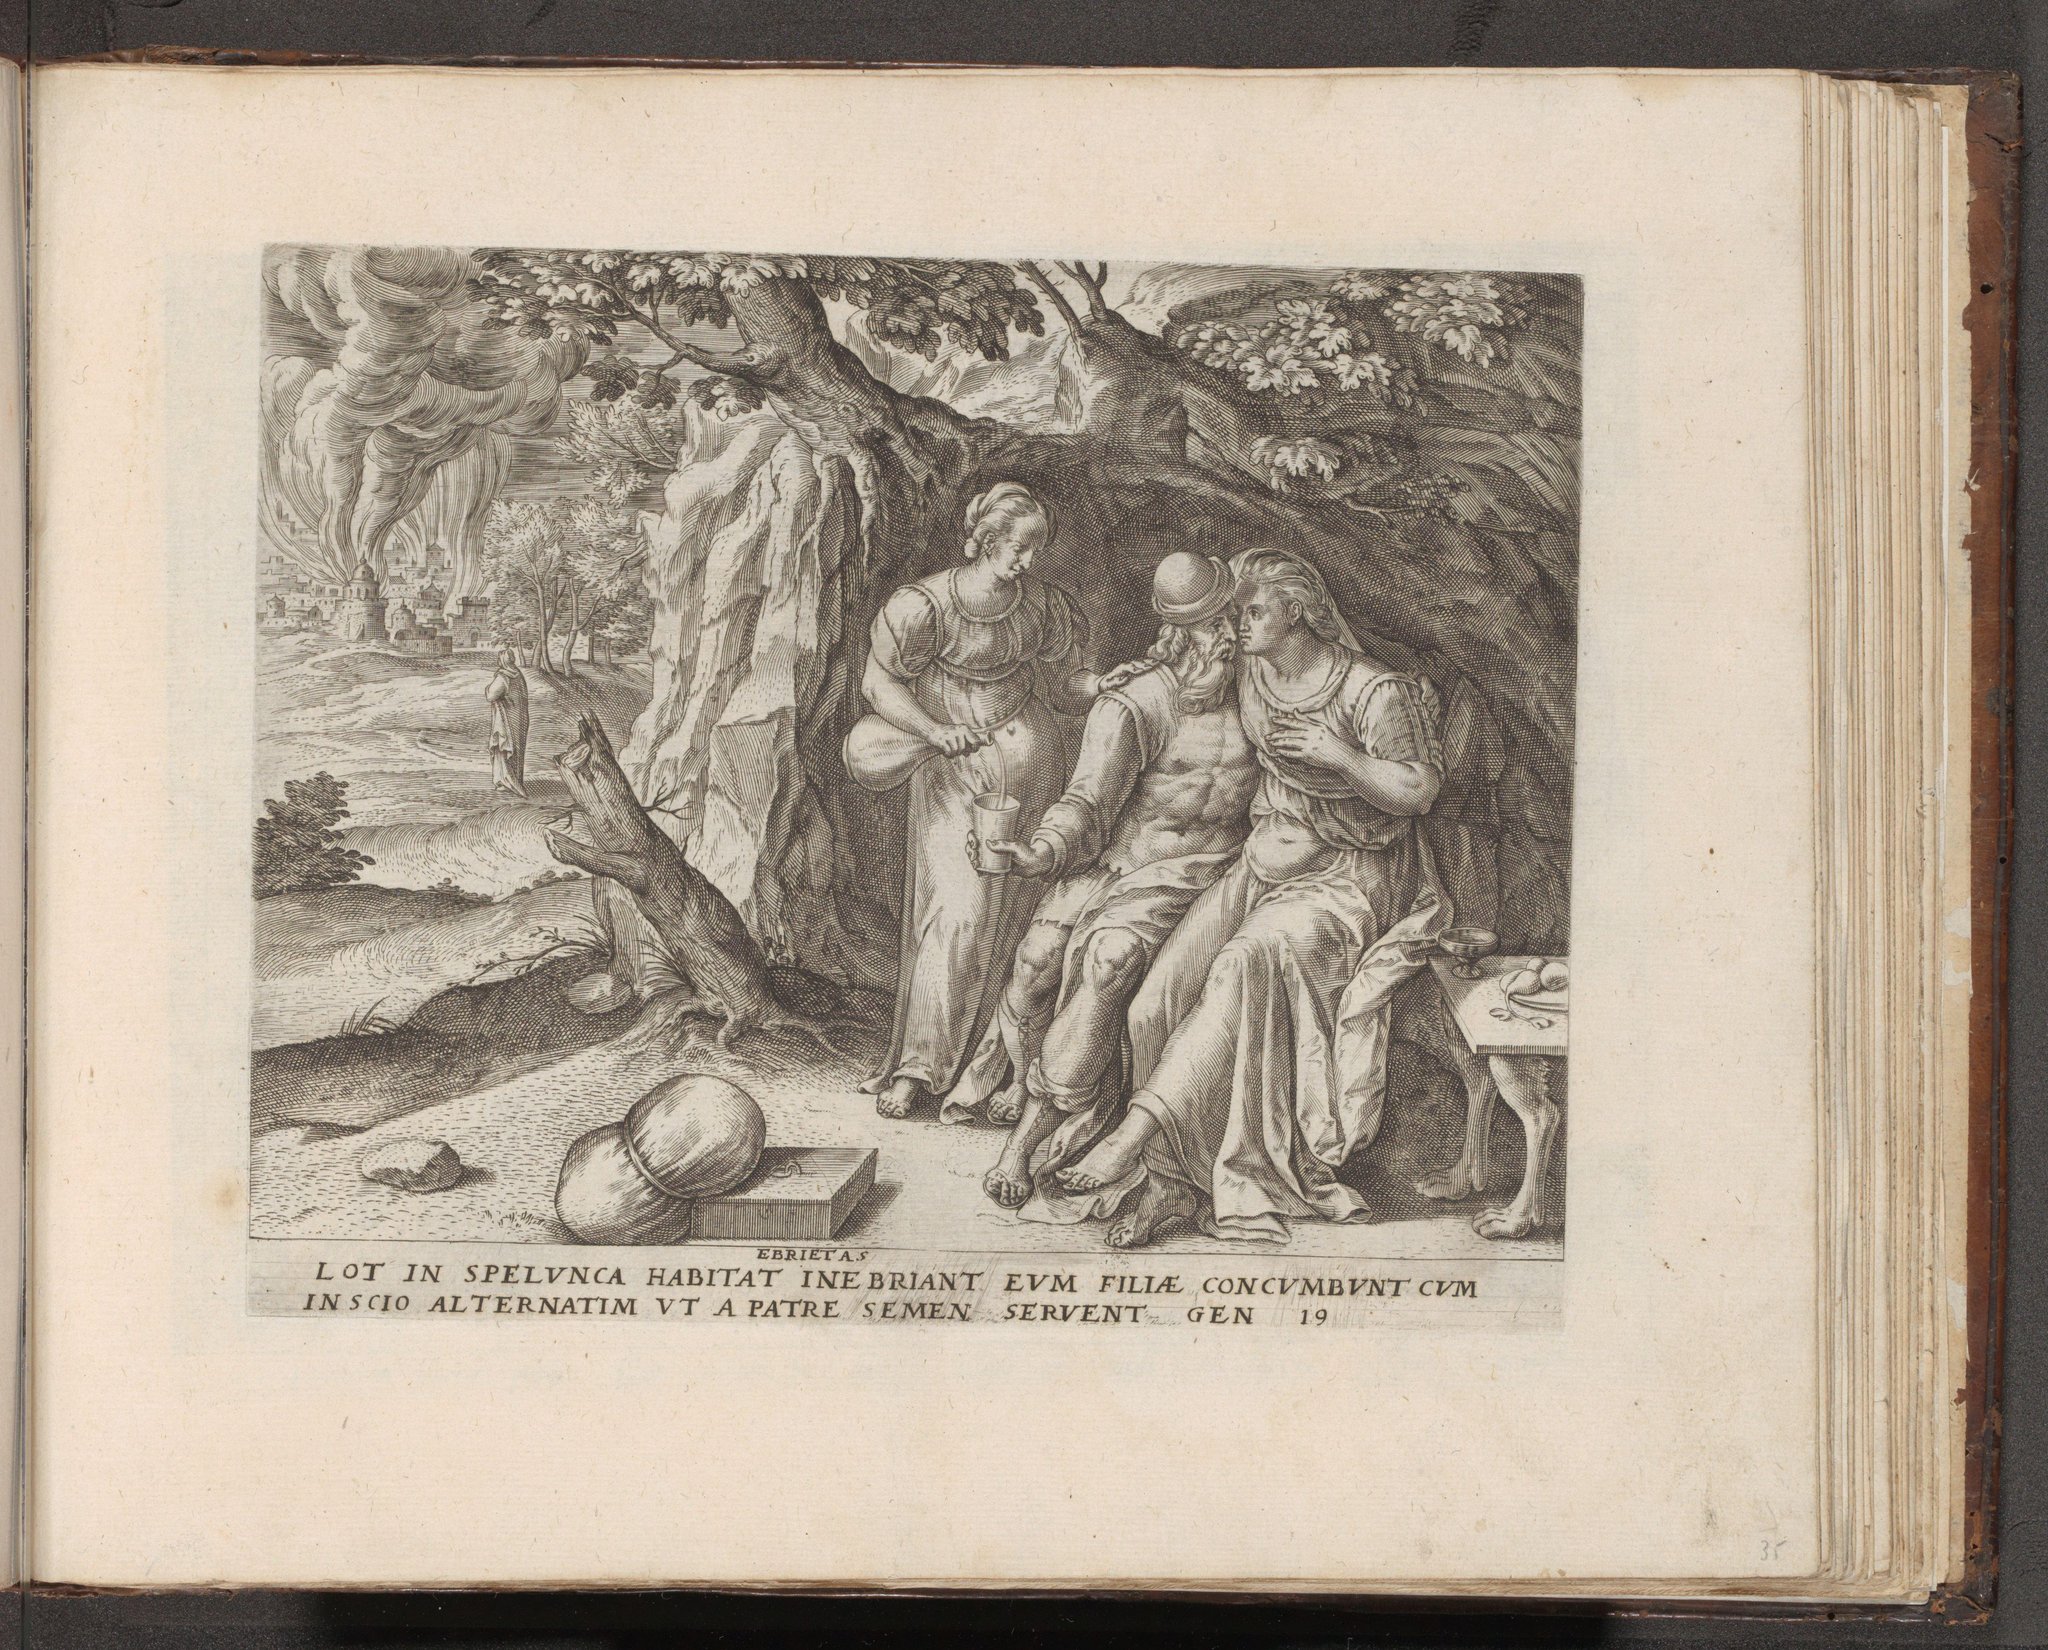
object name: album leaf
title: Historia Loth (...)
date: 1579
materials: paper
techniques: engraving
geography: antwerp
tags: lot's daughters make their father drunk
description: Dit is de eerste staat van drie van de tweede editie van deze prent. De eerste editie werd mogelijk door Hieronymus Cock uitgegeven. De plaat kwam, vermoedelijk na de dood van Cock, in handen van Gerard de Jode. De voorstelling van de plaat werd toen compleet verwijderd en er kwam een iets andere compositie voor in de plaats. Alleen de tekst bleef ongewijzigd.